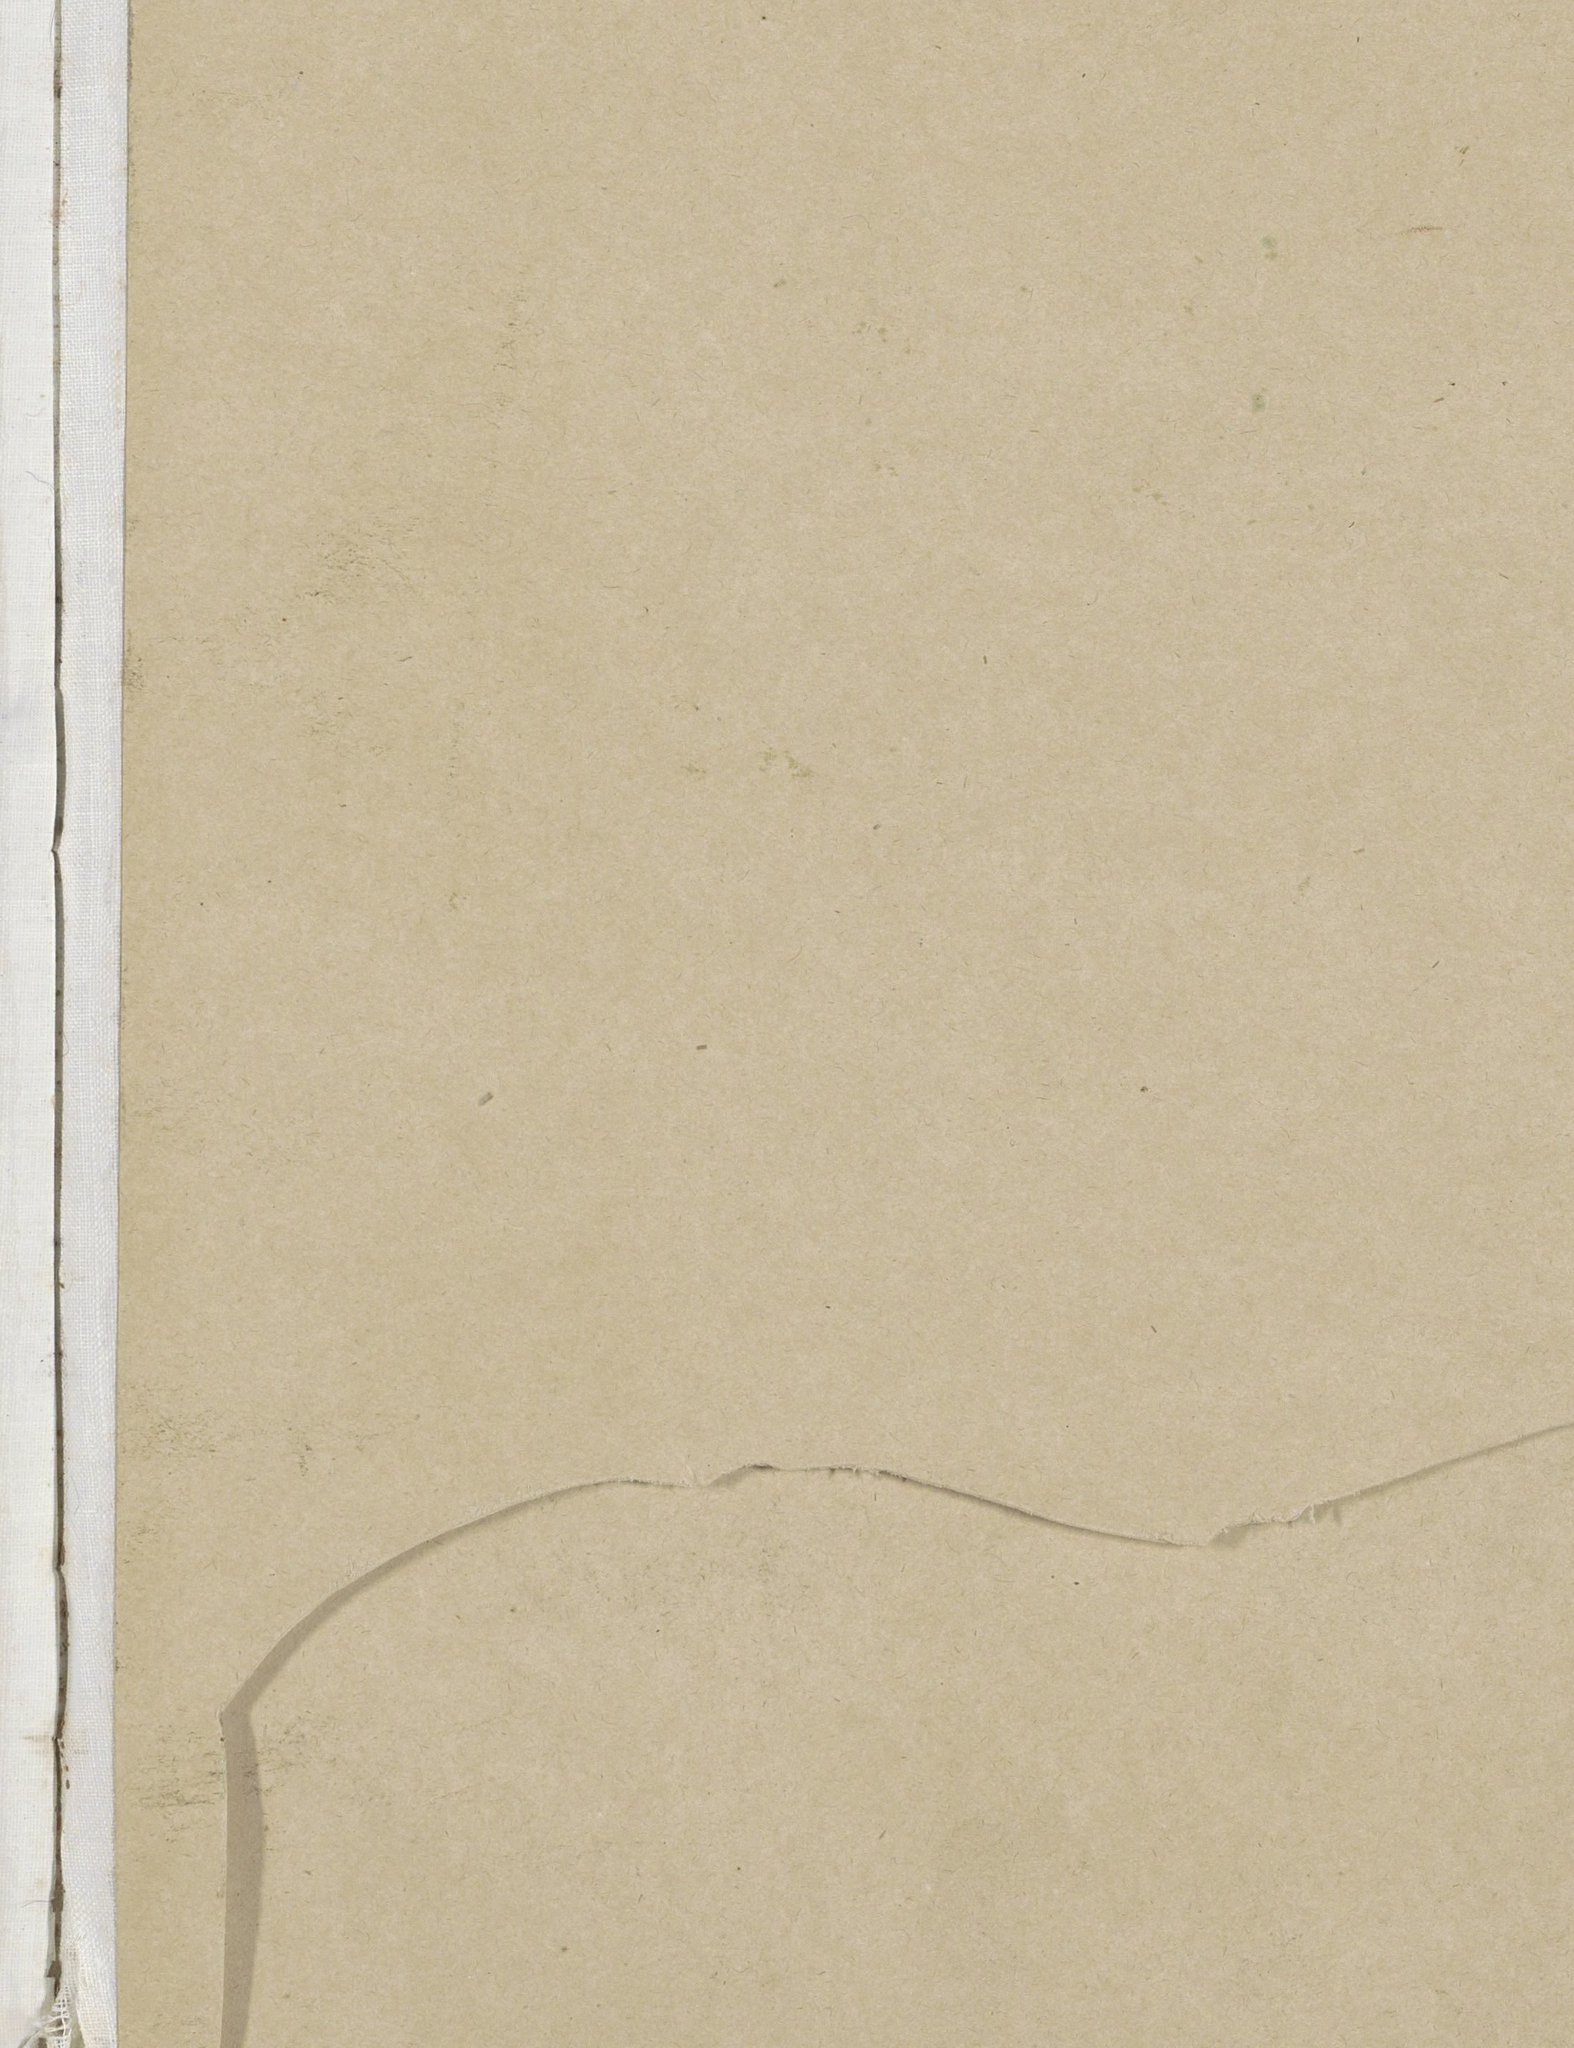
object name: sketchbook leaf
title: Voet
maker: willem witsen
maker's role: draughtsman, painter, print maker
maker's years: 1860-1923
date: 1874-1923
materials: chalk, paper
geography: ewijkshoeve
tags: foot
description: Pagina 3 uit een schetsboek met 72 bladen.